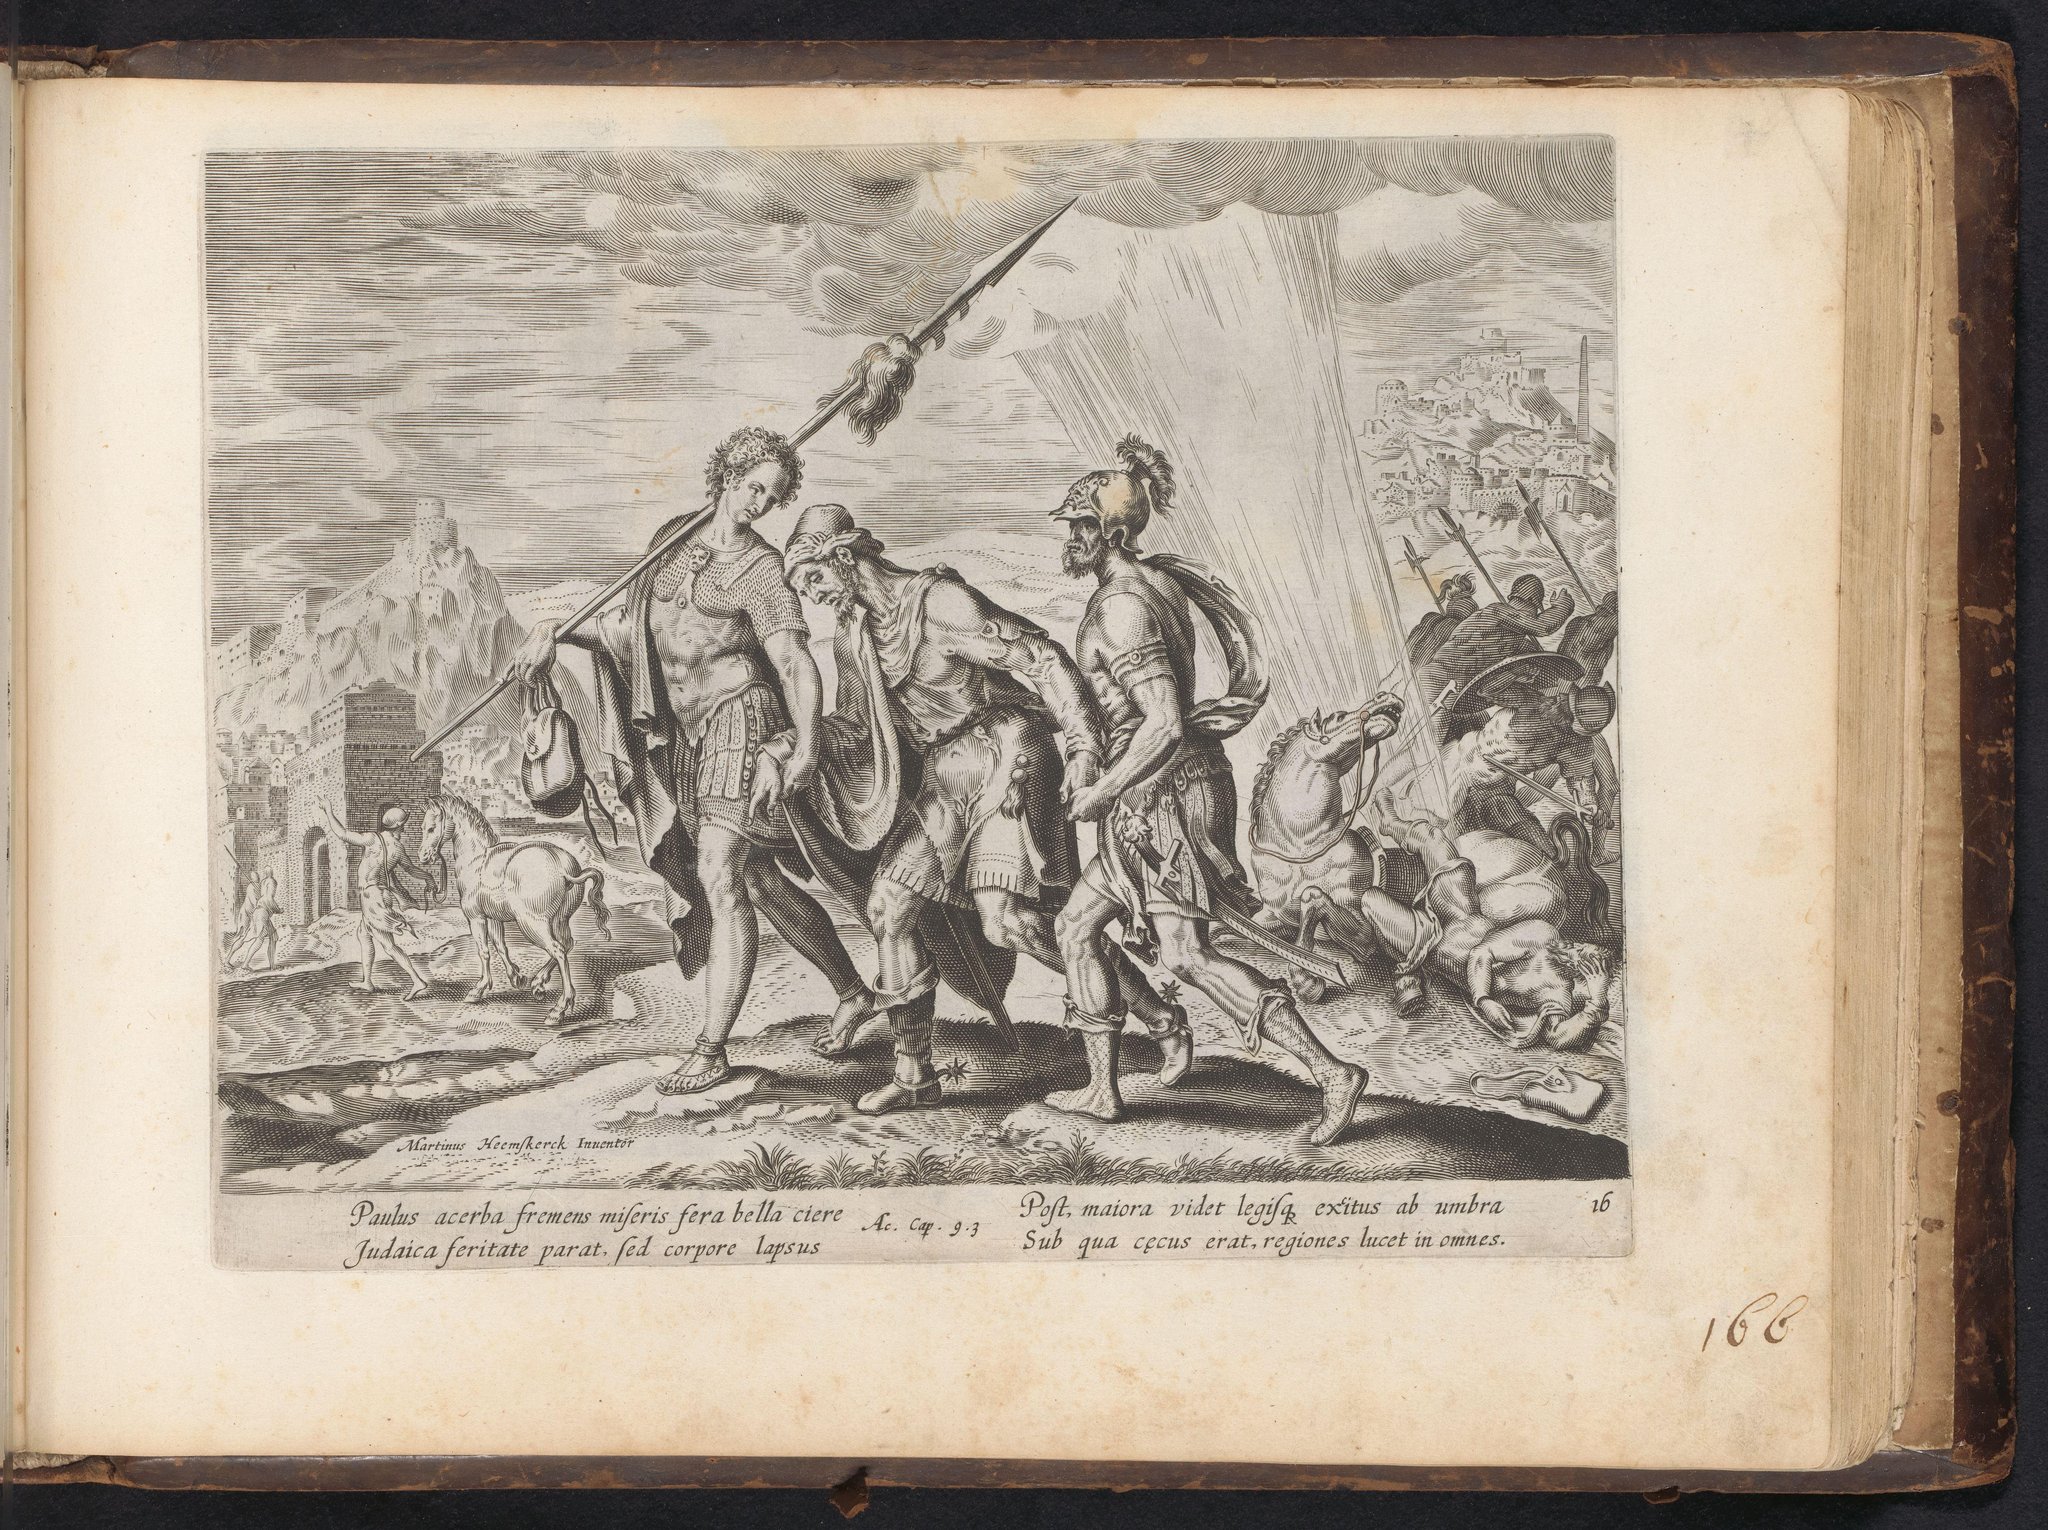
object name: print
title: Handelingen van de apostelen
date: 1643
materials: paper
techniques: engraving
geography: alkmaar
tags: on the way to damascus christ appears to saul, who falls from his horse and is blinded by the light, blind saul is led to damascus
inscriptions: number: ‘166’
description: Op weg naar Damascus wordt Saulus getroffen door een lichtstraal uit de hemel. Hij wordt door de lichtstraal van zijn paard geworpen en ligt op de grond. Soldaten staan rondom hem in paniek. Vervolgens wordt de blinde Saulus door soldaten begeleid naar Damascus, waar hij genezen wordt van zijn blindheid en de naam Paulus aanneemt. Onder de voorstelling een verwijzing in het Latijn naar de Bijbeltekst in Hand. 9:3. Deze prent maakt deel uit van een album.